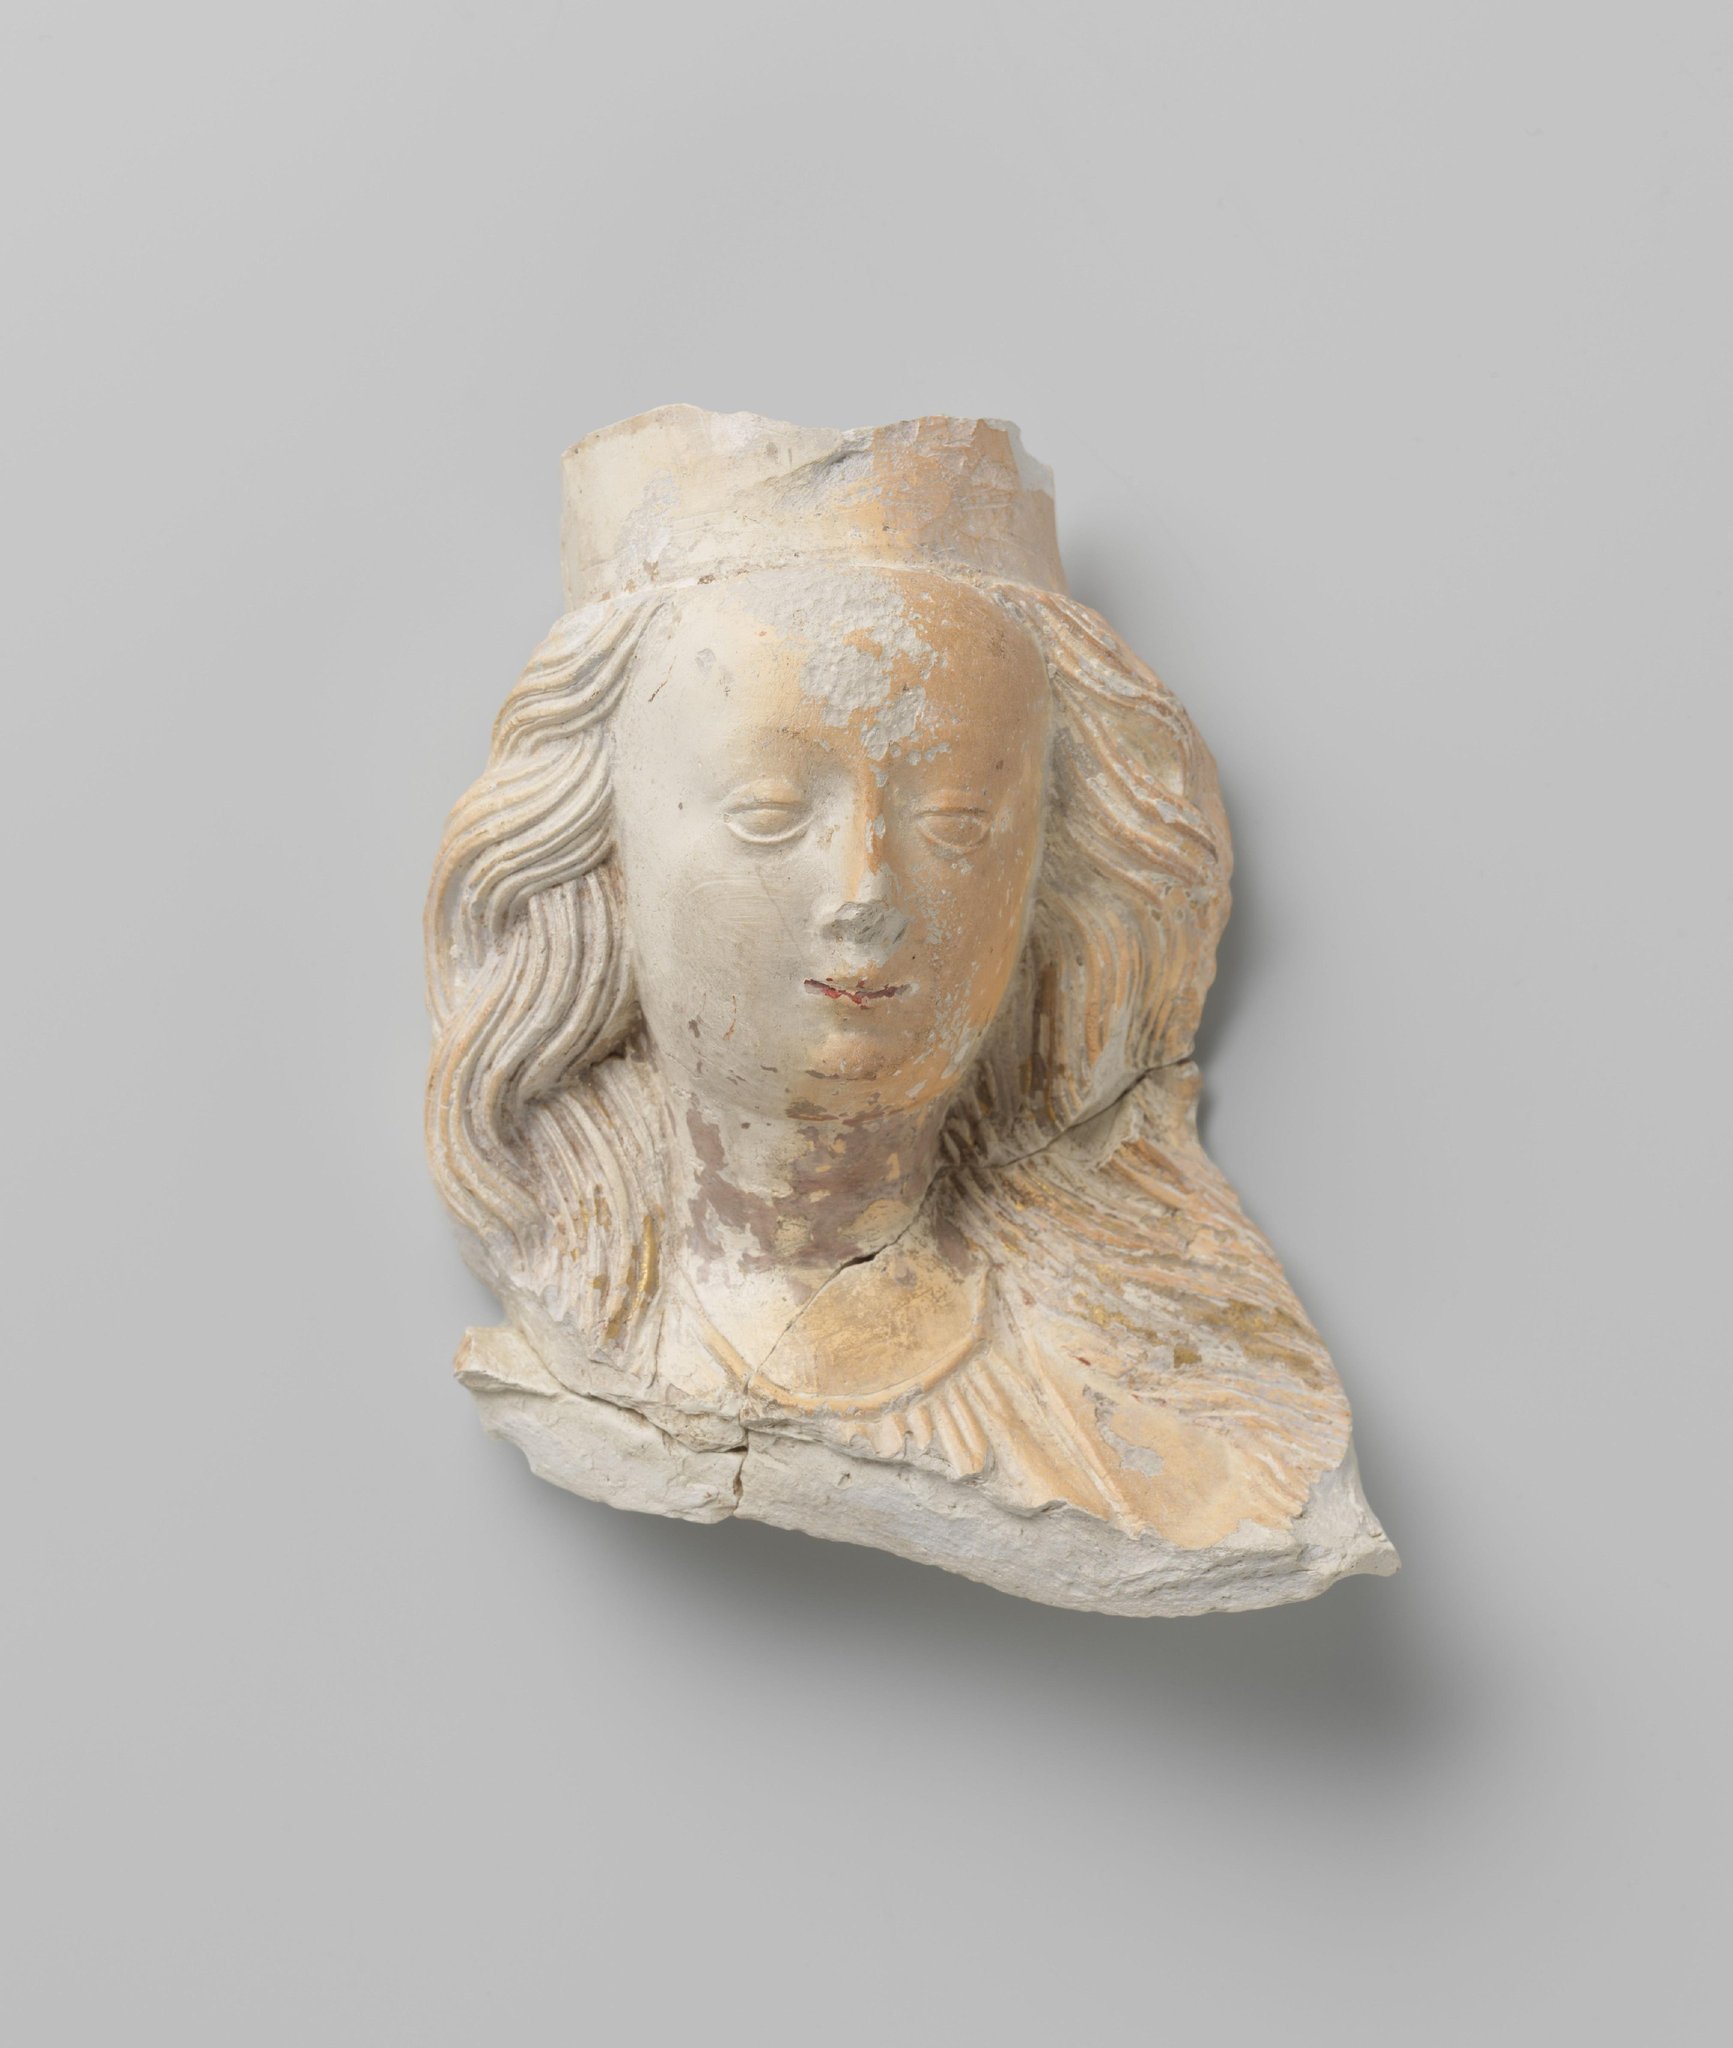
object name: sculpture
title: Head of the Virgin with child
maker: Anonymous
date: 1470-1480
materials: clay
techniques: gilding, polychromy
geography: utrecht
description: In the late Middle Ages, modelling with pipe clay (which is white after firing) became a flourishing branch of decorative art in the Low Countries. The inexpensive material and the use of moulds opened the way to large-scale production of sculptures in this medium, which became an affordable alternative to wooden or ivory figurines. This is a fragment of a statue of the Virgin Mary that was hidden in the tower of the Oude Kerk in Soest during the Iconoclastic Fury in 1566.